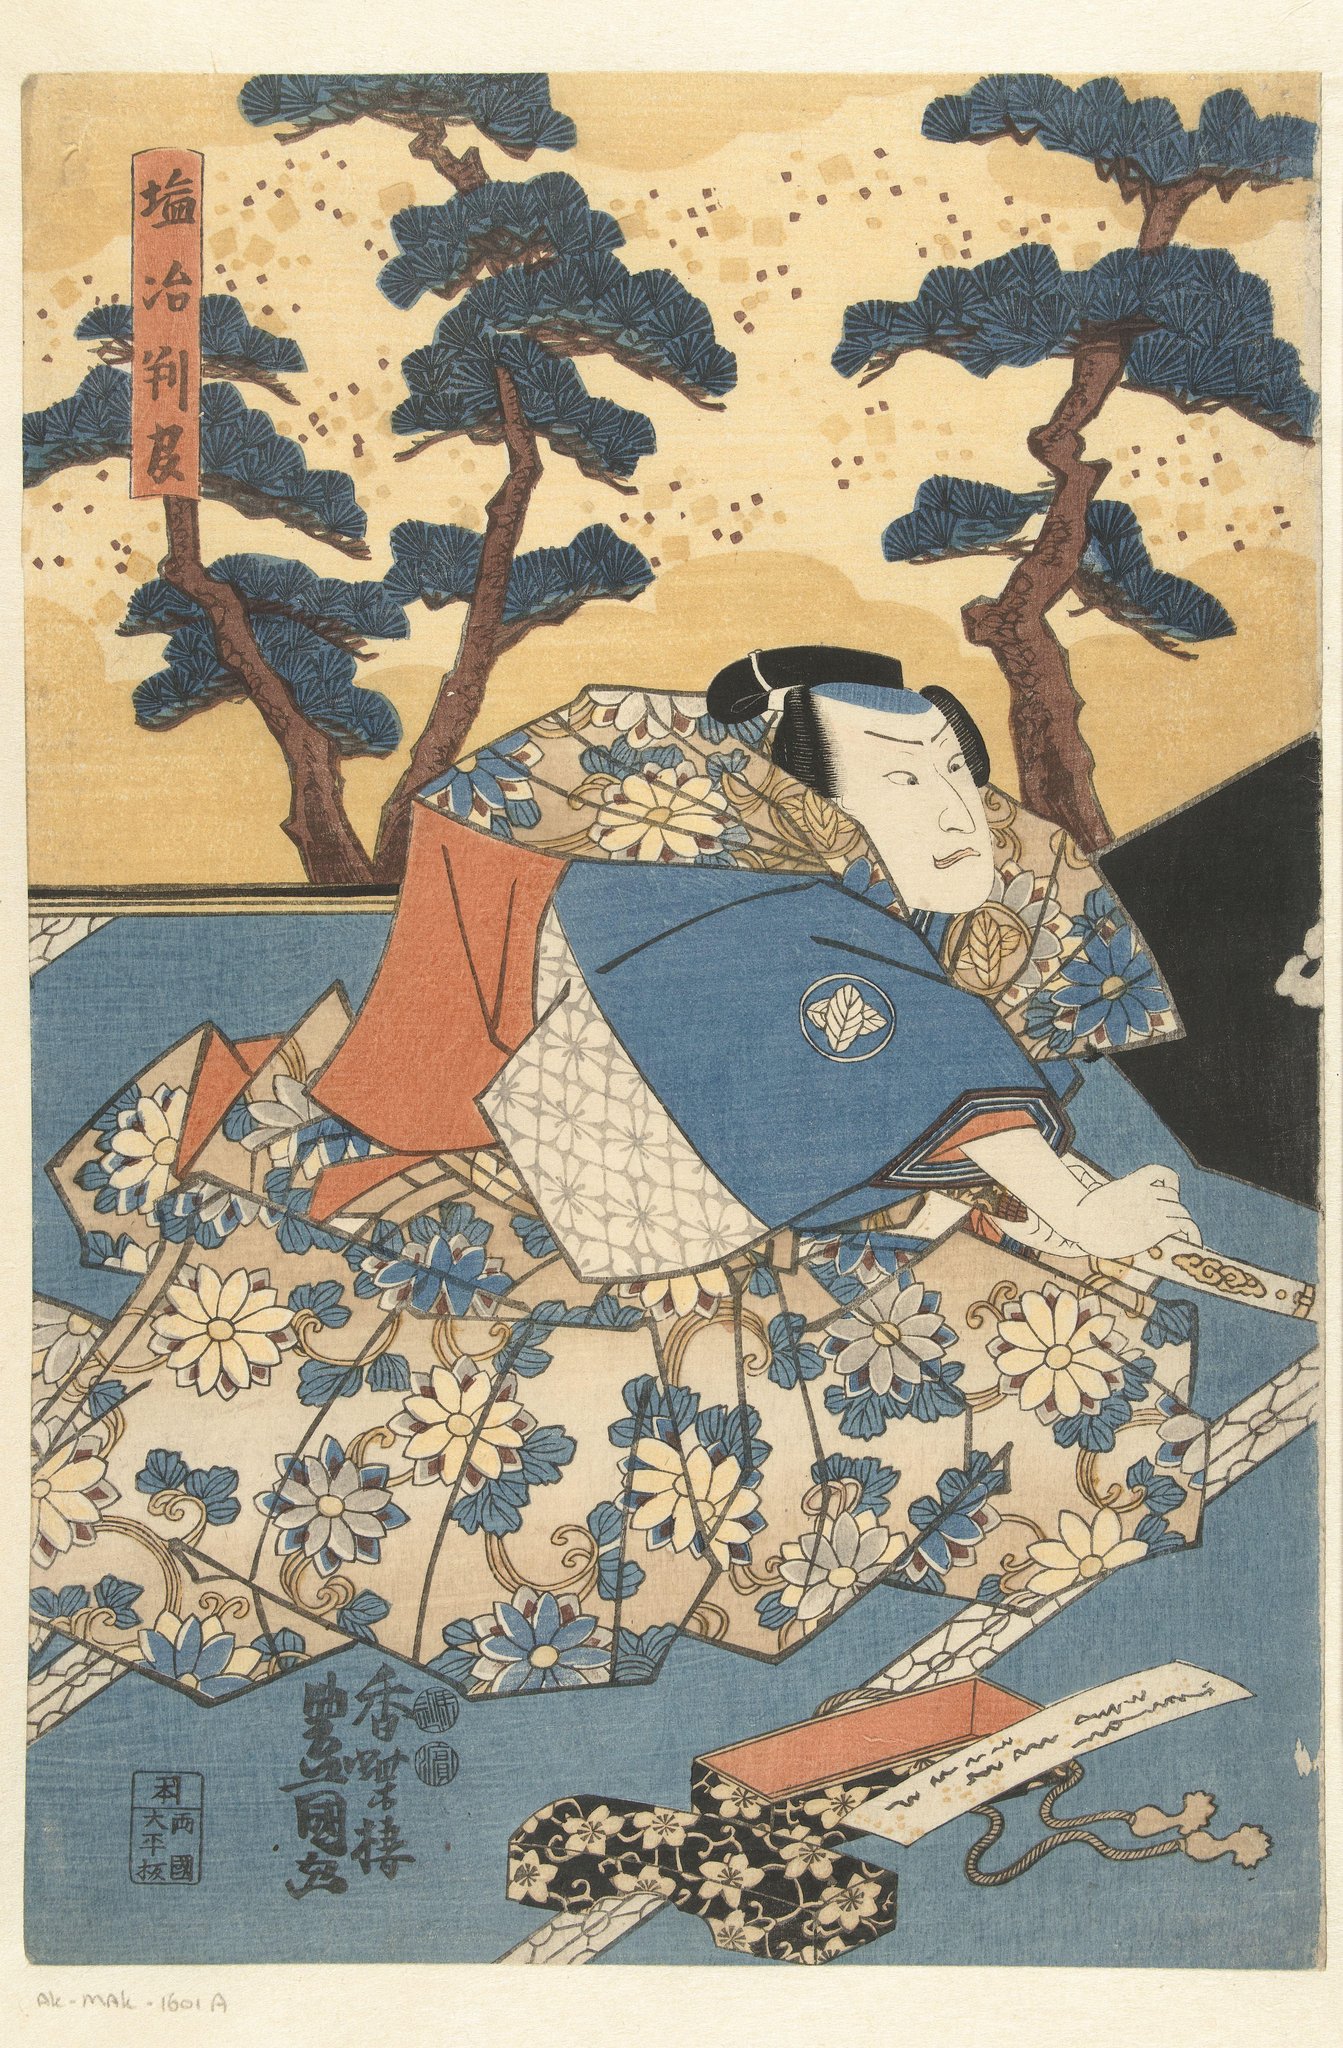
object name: print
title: Acteur als hoveling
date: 1849-1853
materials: paper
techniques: woodcut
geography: tokyo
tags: fan, portrait of actor, actress, screen, folding screen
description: Acteur, zittend met waaier, in kamer met goudkleurig kamerscherm met schildering van pijnbomen.